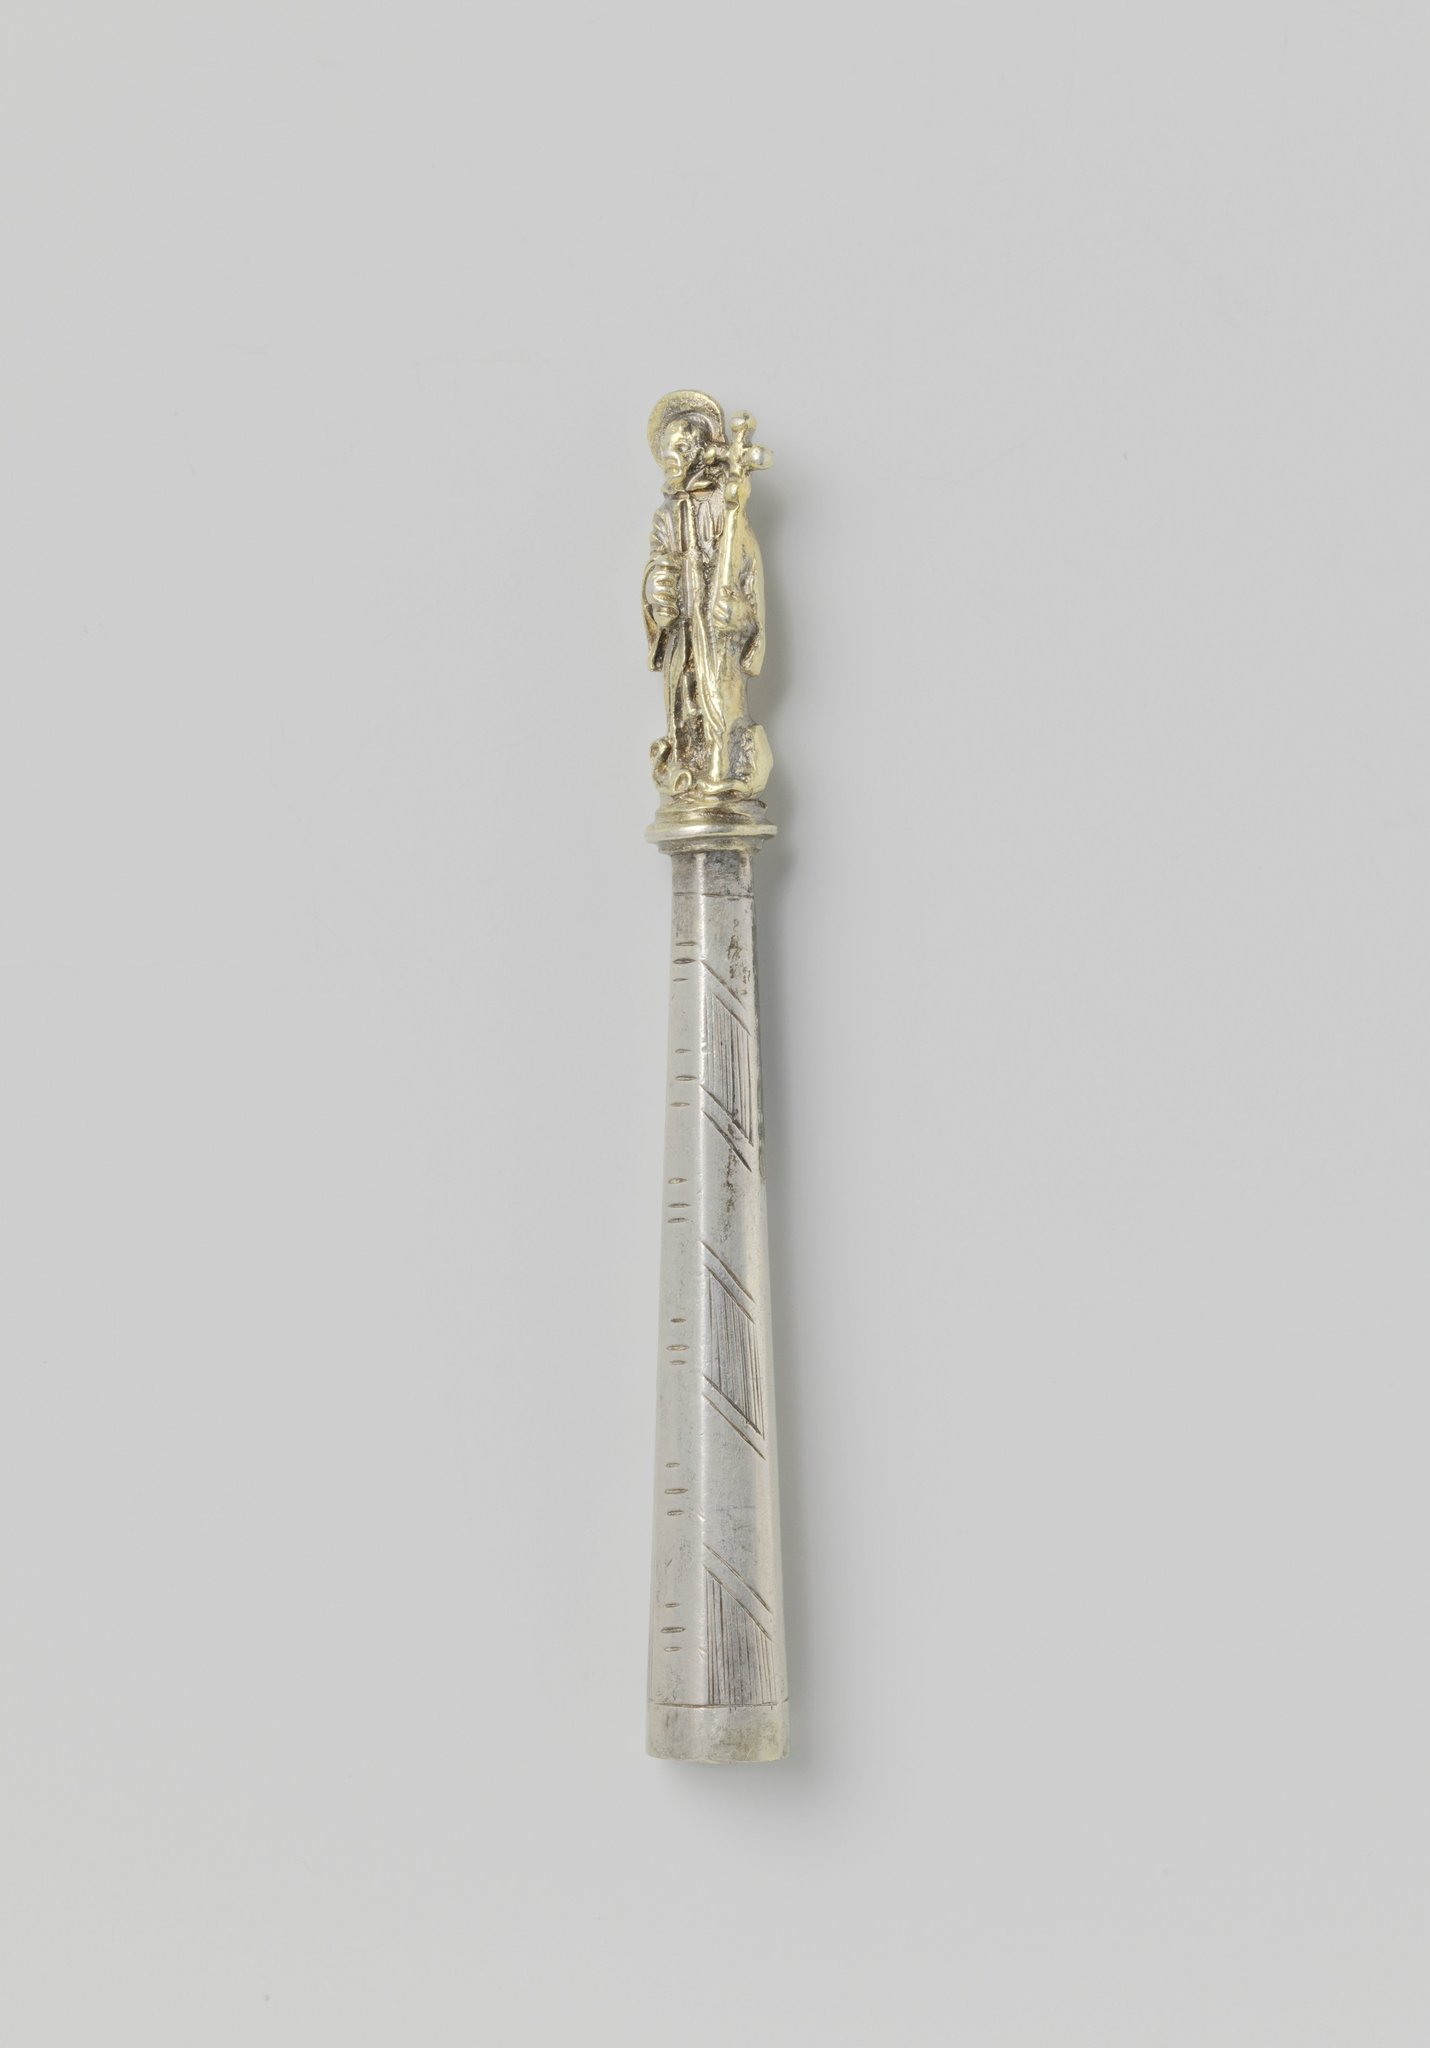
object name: lepelsteel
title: Lepelsteel met beeltenis apostel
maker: Anonymous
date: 1600-1625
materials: silver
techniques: gilding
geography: germany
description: Lepelsteel van zilver met aan het uiteinde een vergulde apostel.